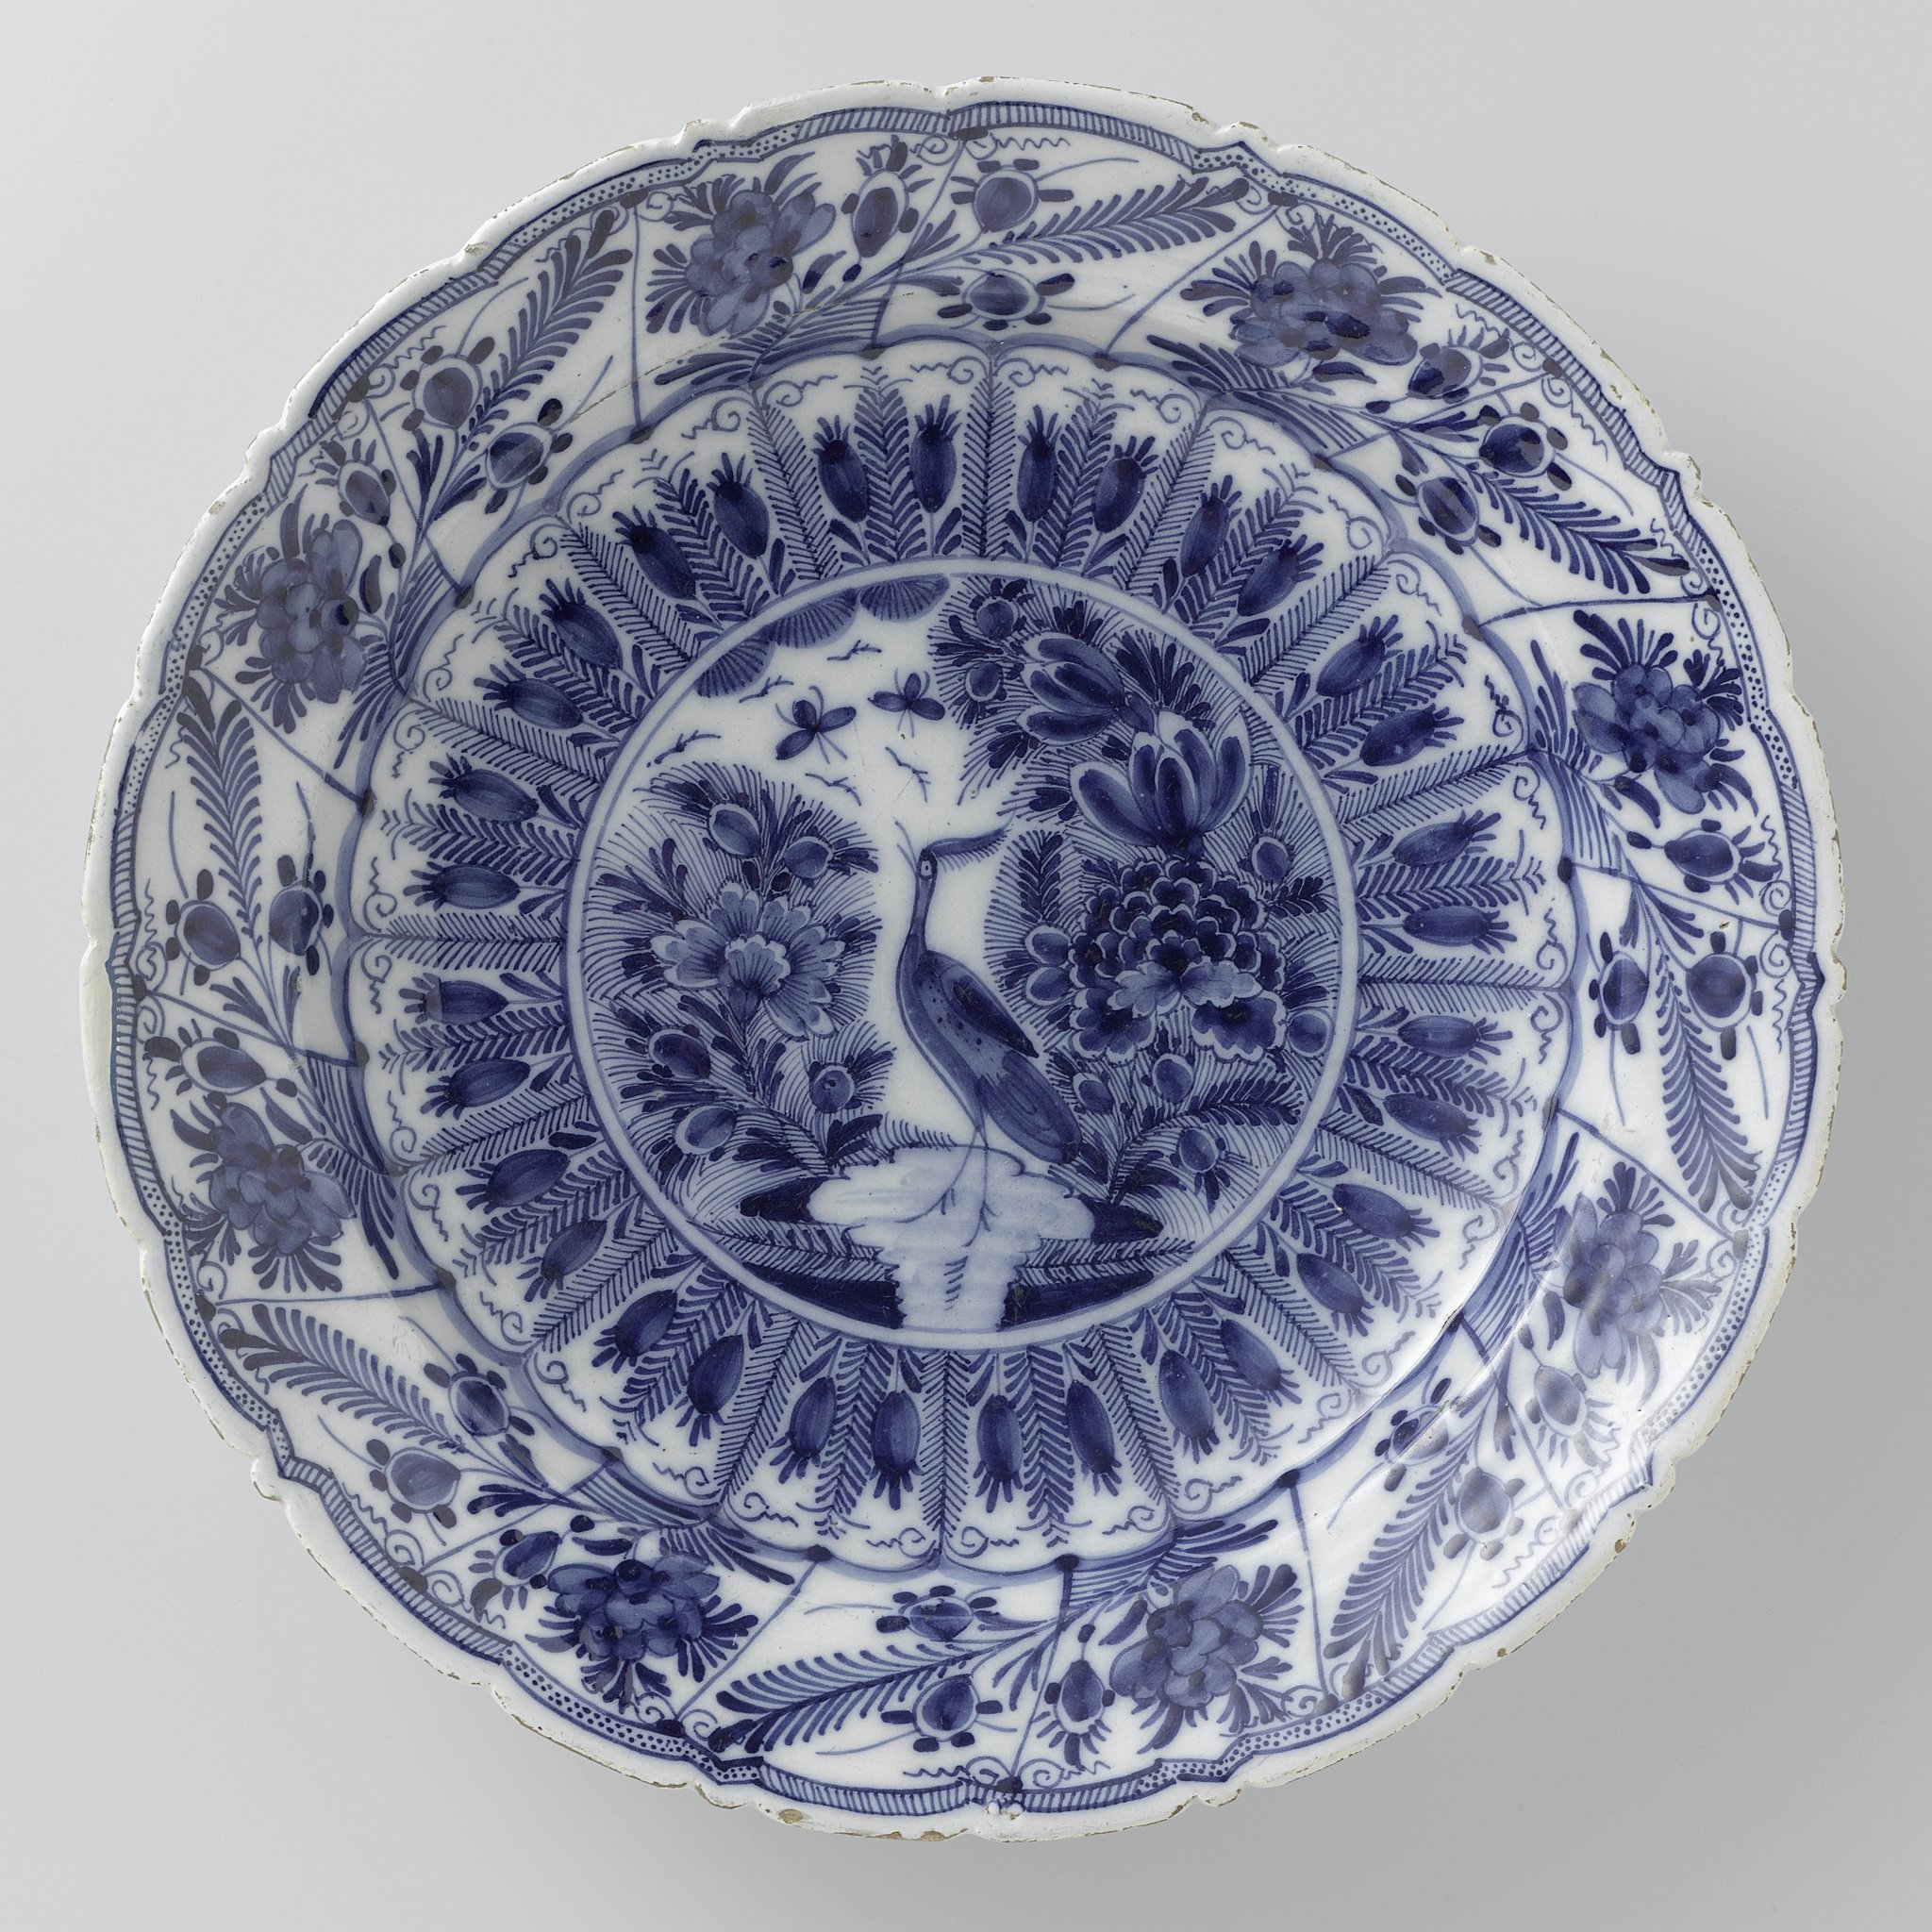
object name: platter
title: Schotel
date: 1750-1800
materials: earthenware, glaze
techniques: painted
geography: delft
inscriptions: inscription: ‘[...]/ 970/ Ar(?) pot/ [...] st’, mark: ‘figuratief teken klauw/ 490’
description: Ronde schotel van blauw beschilderde faience, met een geschulpte rand en versierd met het reigerpatroon. De schotel is gemerkt met de merken van de plateelbakkerij De Porceleijne Claeuw.